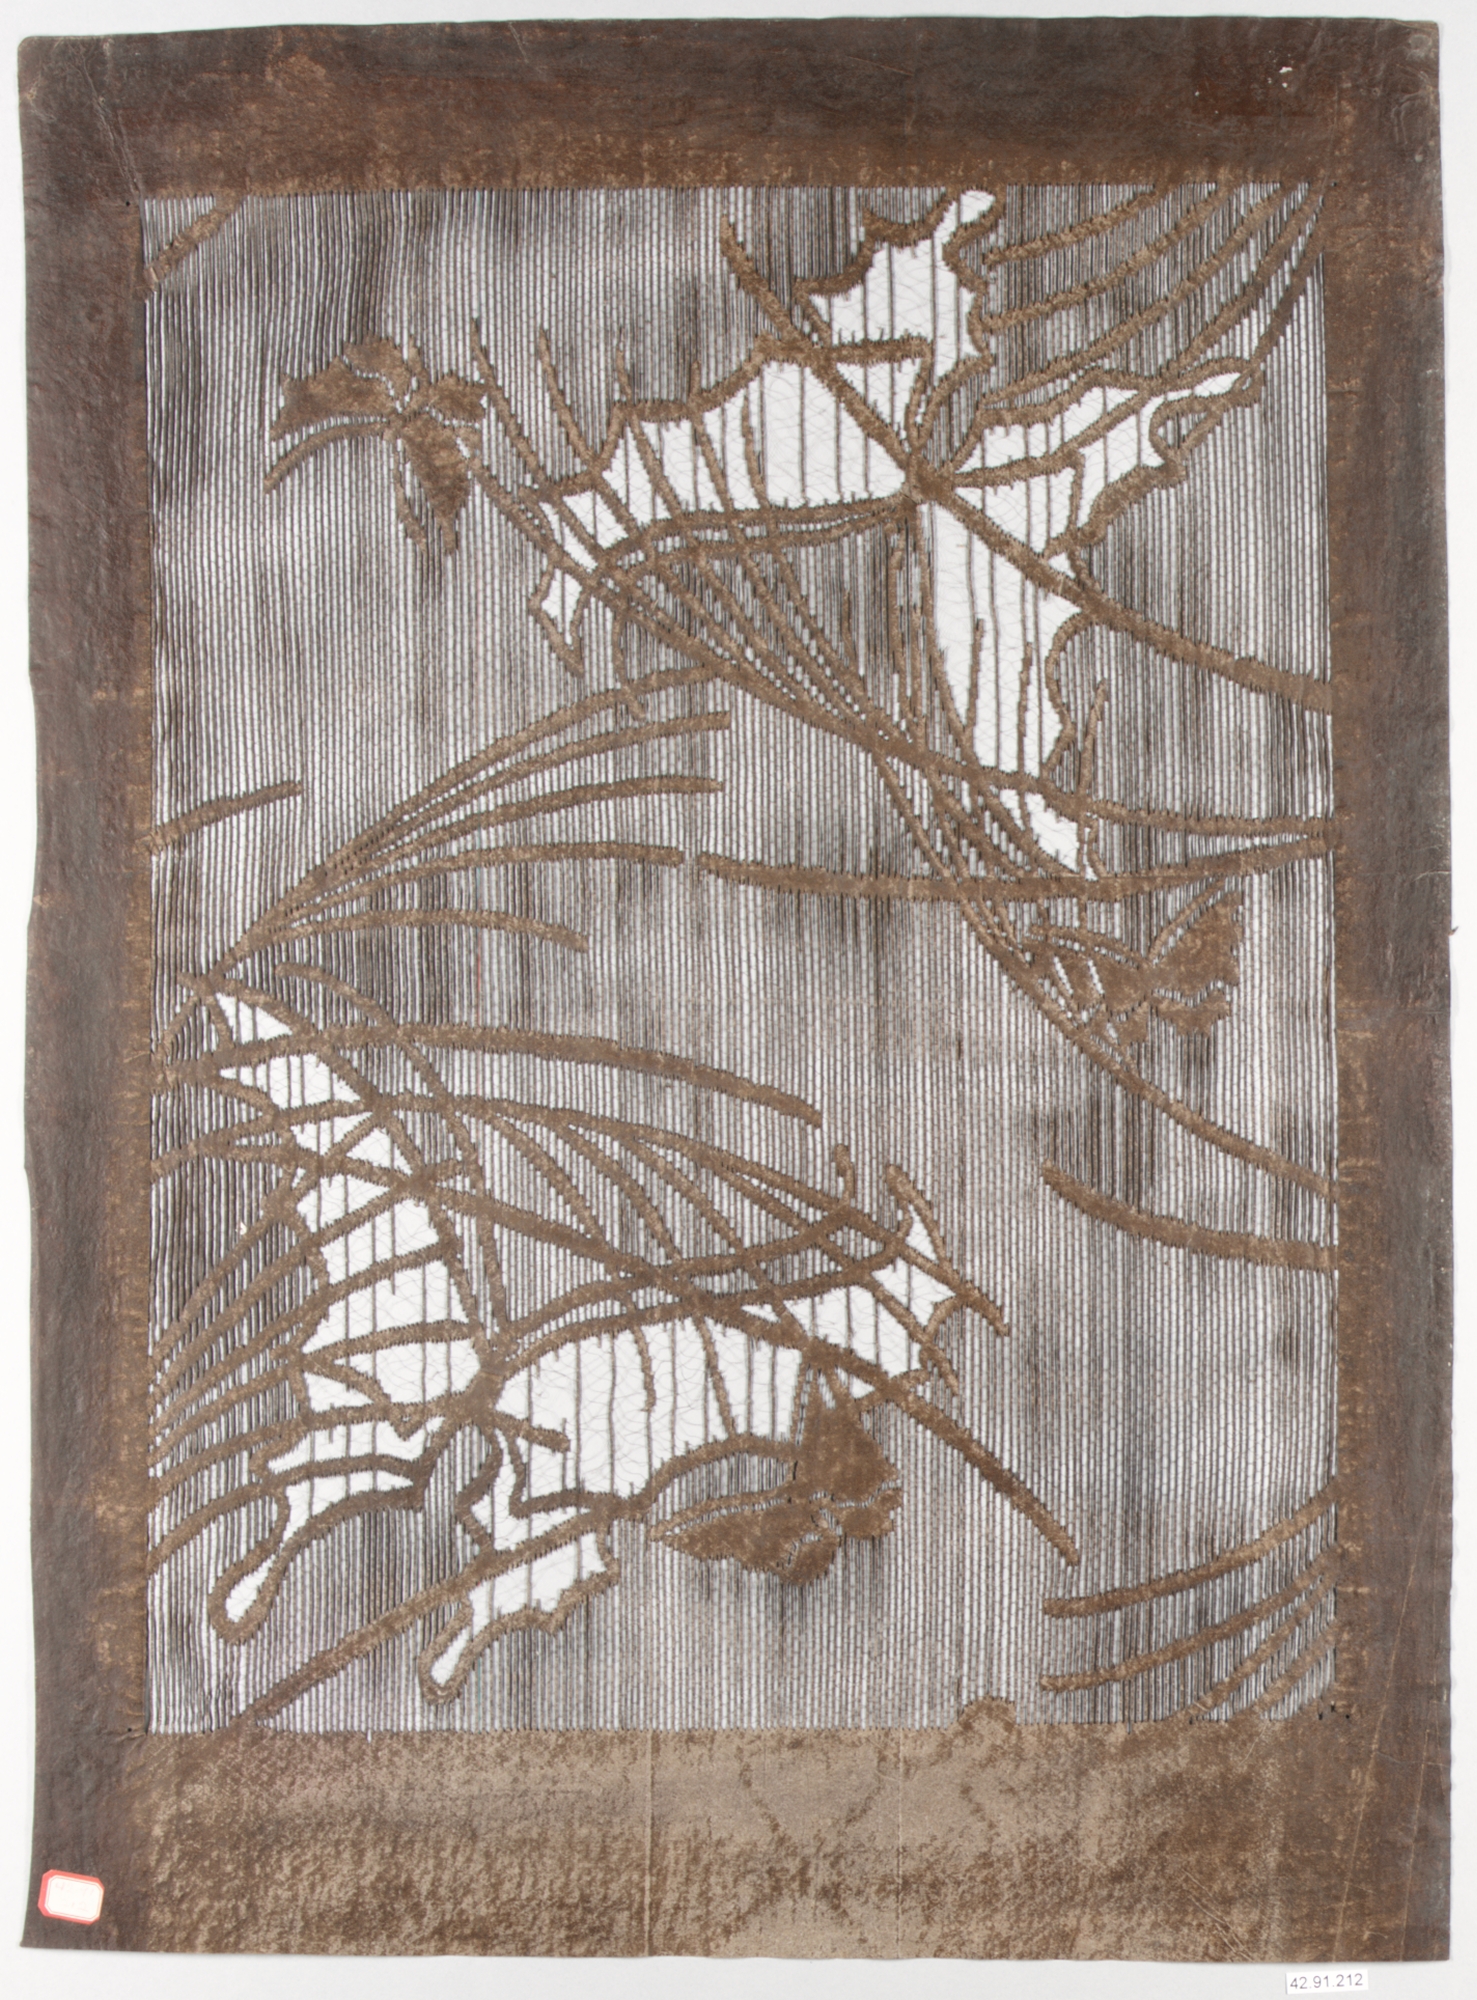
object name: stencil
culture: japanese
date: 1801-1900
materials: paper, silk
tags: butterflies